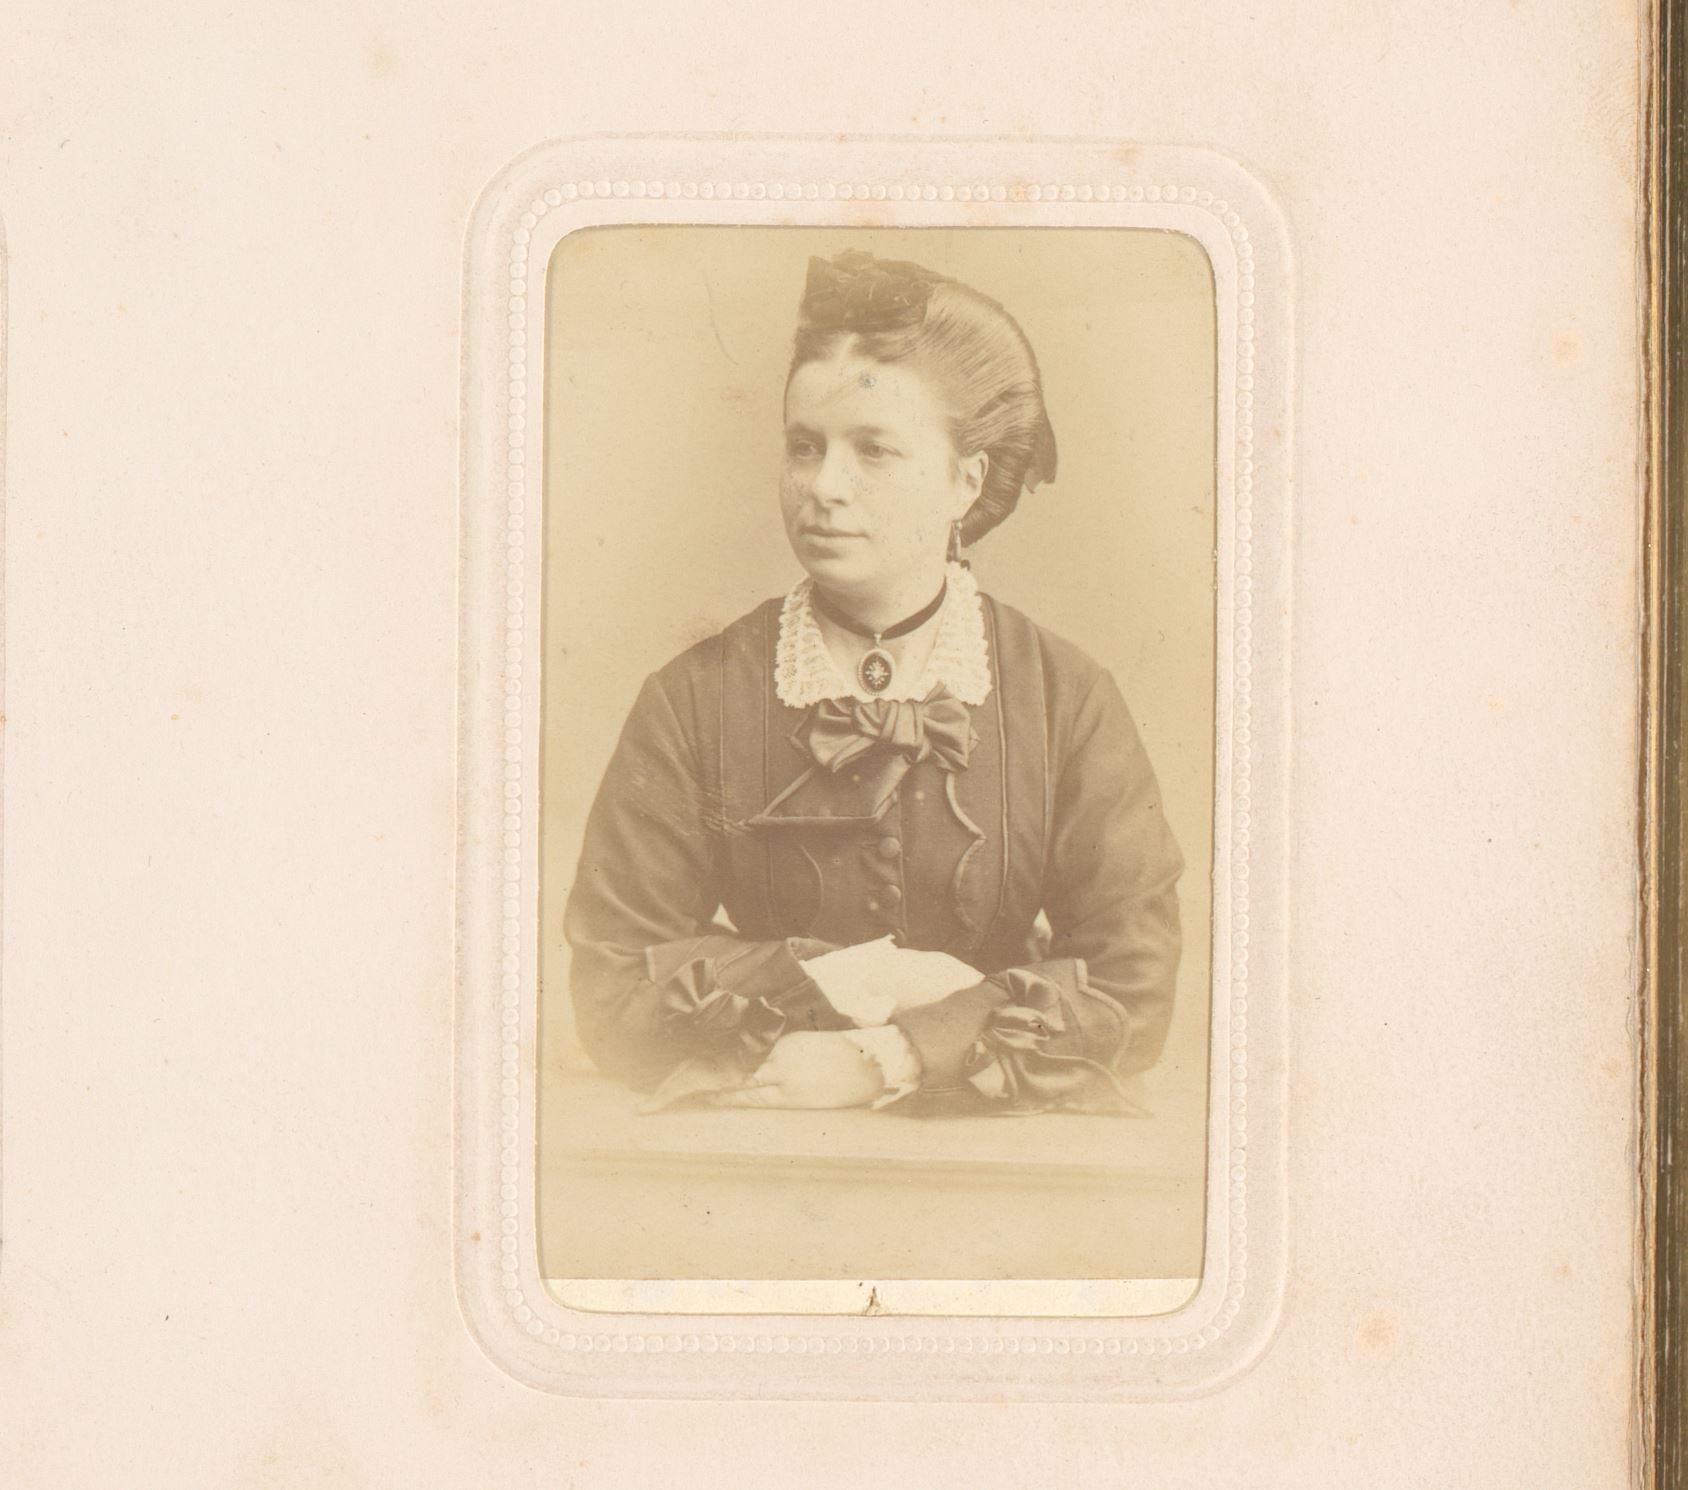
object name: album leaf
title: Portret van een vrouw met halsketting, leunend op een balustrade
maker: a. georges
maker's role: fotograaf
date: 1855-1880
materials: cardboard, paper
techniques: albumen print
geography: versailles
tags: historical persons - bb - woman, balustrade, necklace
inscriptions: inscription: ‘GEORGES, Phot. - VERSAILLES.’